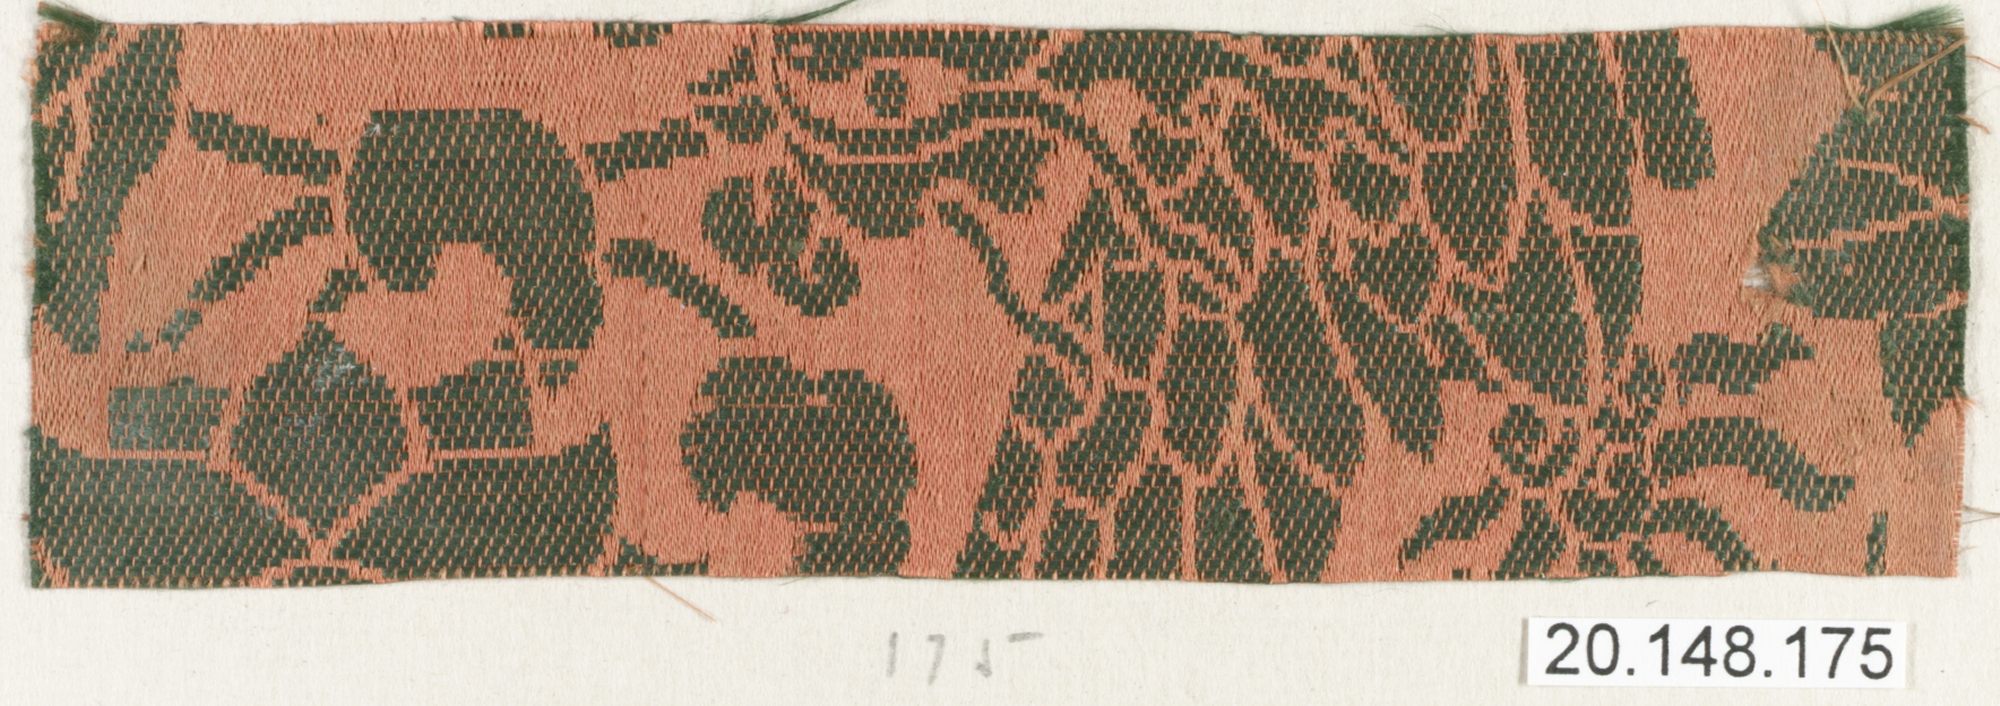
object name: piece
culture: japanese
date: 1501-1600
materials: silk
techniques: compound weave